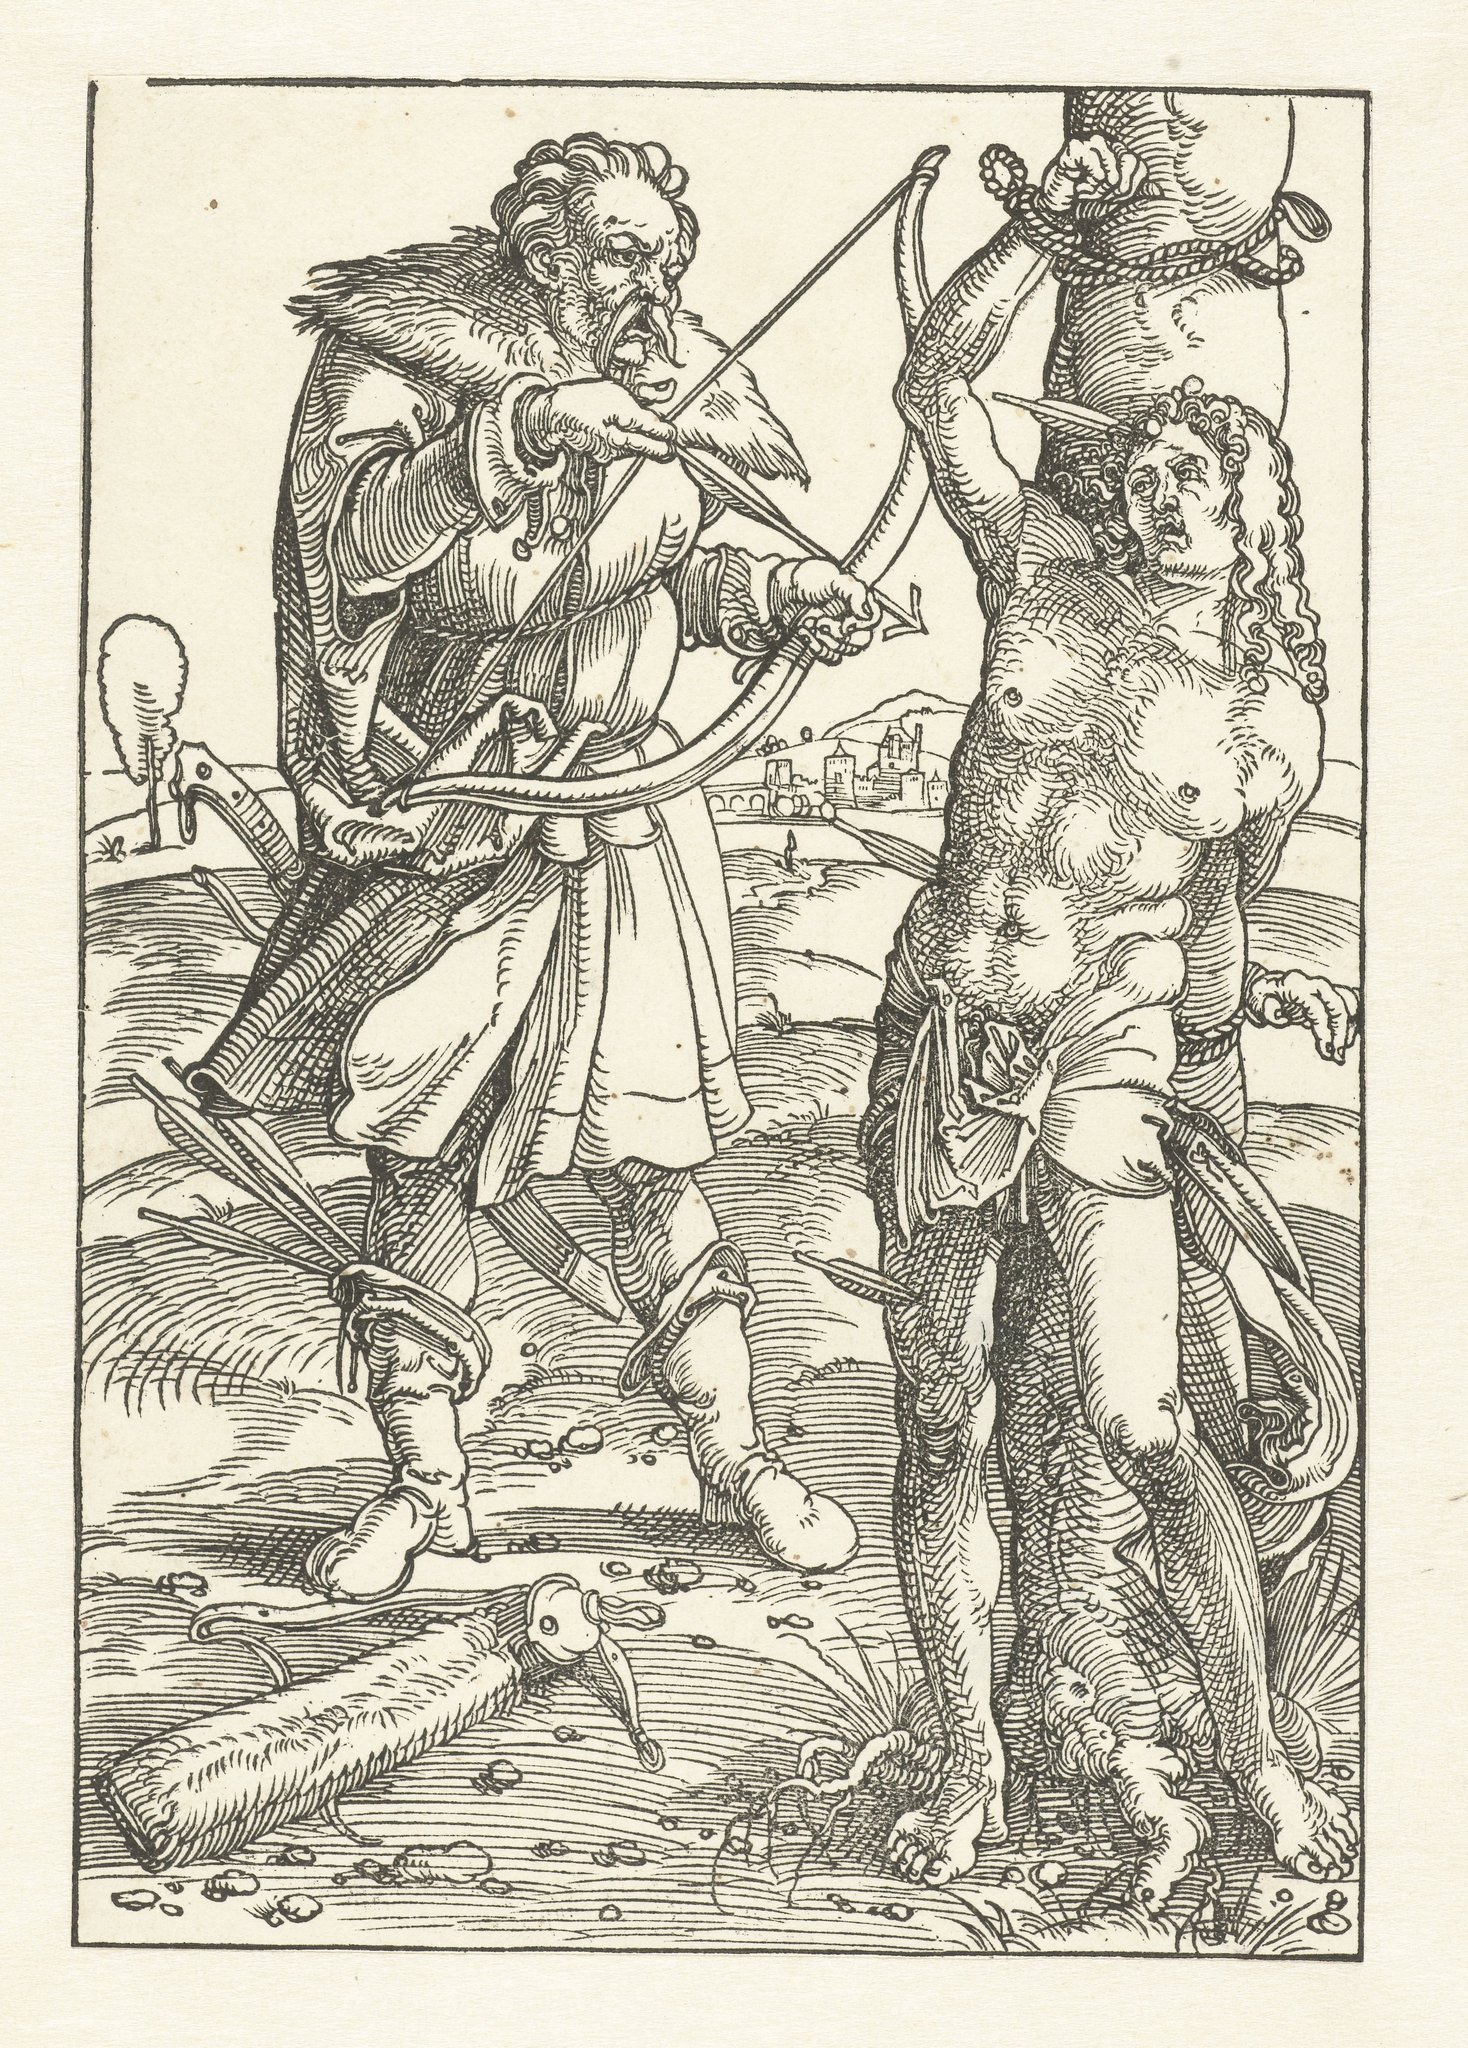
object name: print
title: Sebastiaan wordt beschoten met pijlen door beul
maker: hans baldung grien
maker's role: draughtsman, print maker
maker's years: 1484-1545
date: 1505-1507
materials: paper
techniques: woodcut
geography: nuremberg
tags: st. sebastian, tied to a tree or a pillar, is pierced by arrows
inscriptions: collector's mark: Lugt 240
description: De heilige Sebastiaan staat vastgebonden aan een boom rechts en wordt gemarteld door een beul. Deze staat schuin achter Sebastiaan en richt zijn pijl en boog op de heilige. Op de grond ligt een pijlenkoker en de beul heeft een voorrad pijlen in zijn laars gestoken. De kunstenaar moest in de voorstelling een oplossing vinden voor de weergave van Sebastiaan in vooraanzicht en de schietende beul die zijn pijlen op het lichaam richt.